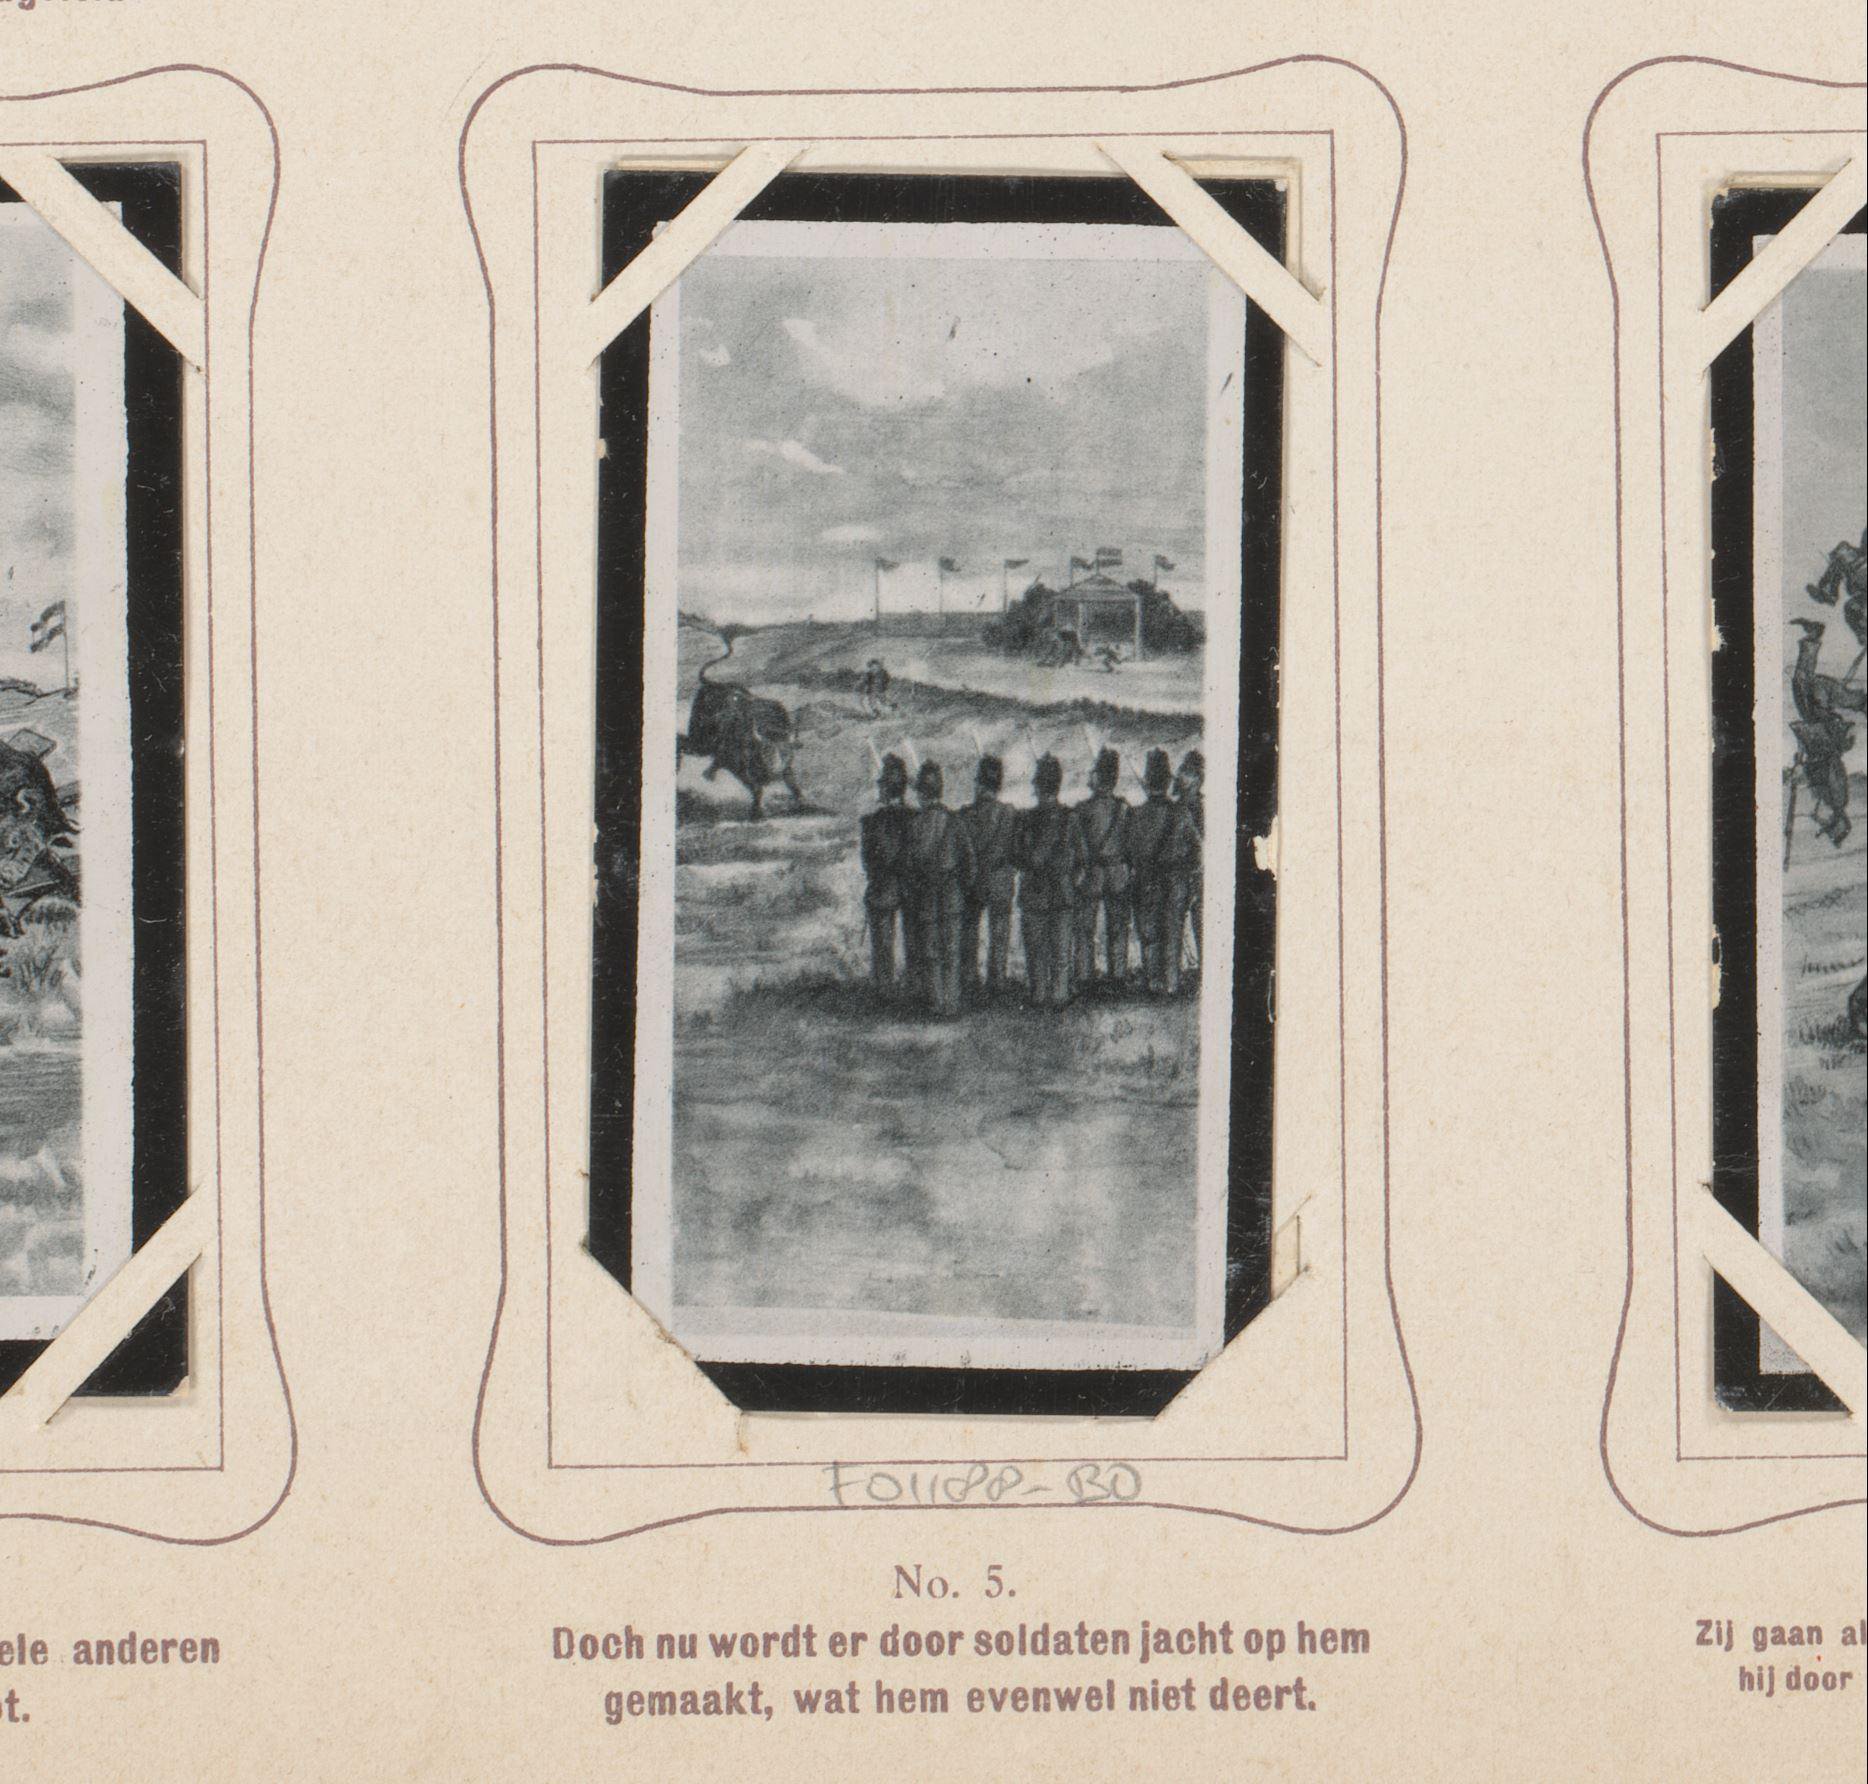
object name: reproduction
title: Reproductie van een tekening van soldaten die jagen op een prijswinnende os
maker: Anonymous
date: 1906-1907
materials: paper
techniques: photograph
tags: prize-ox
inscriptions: inscription: ‘No. 5./ Doch nu wordt er door soldaten jacht op hem gemaakt, wat hem evenwel niet deert.’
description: Deze prent maakt deel uit van een album.